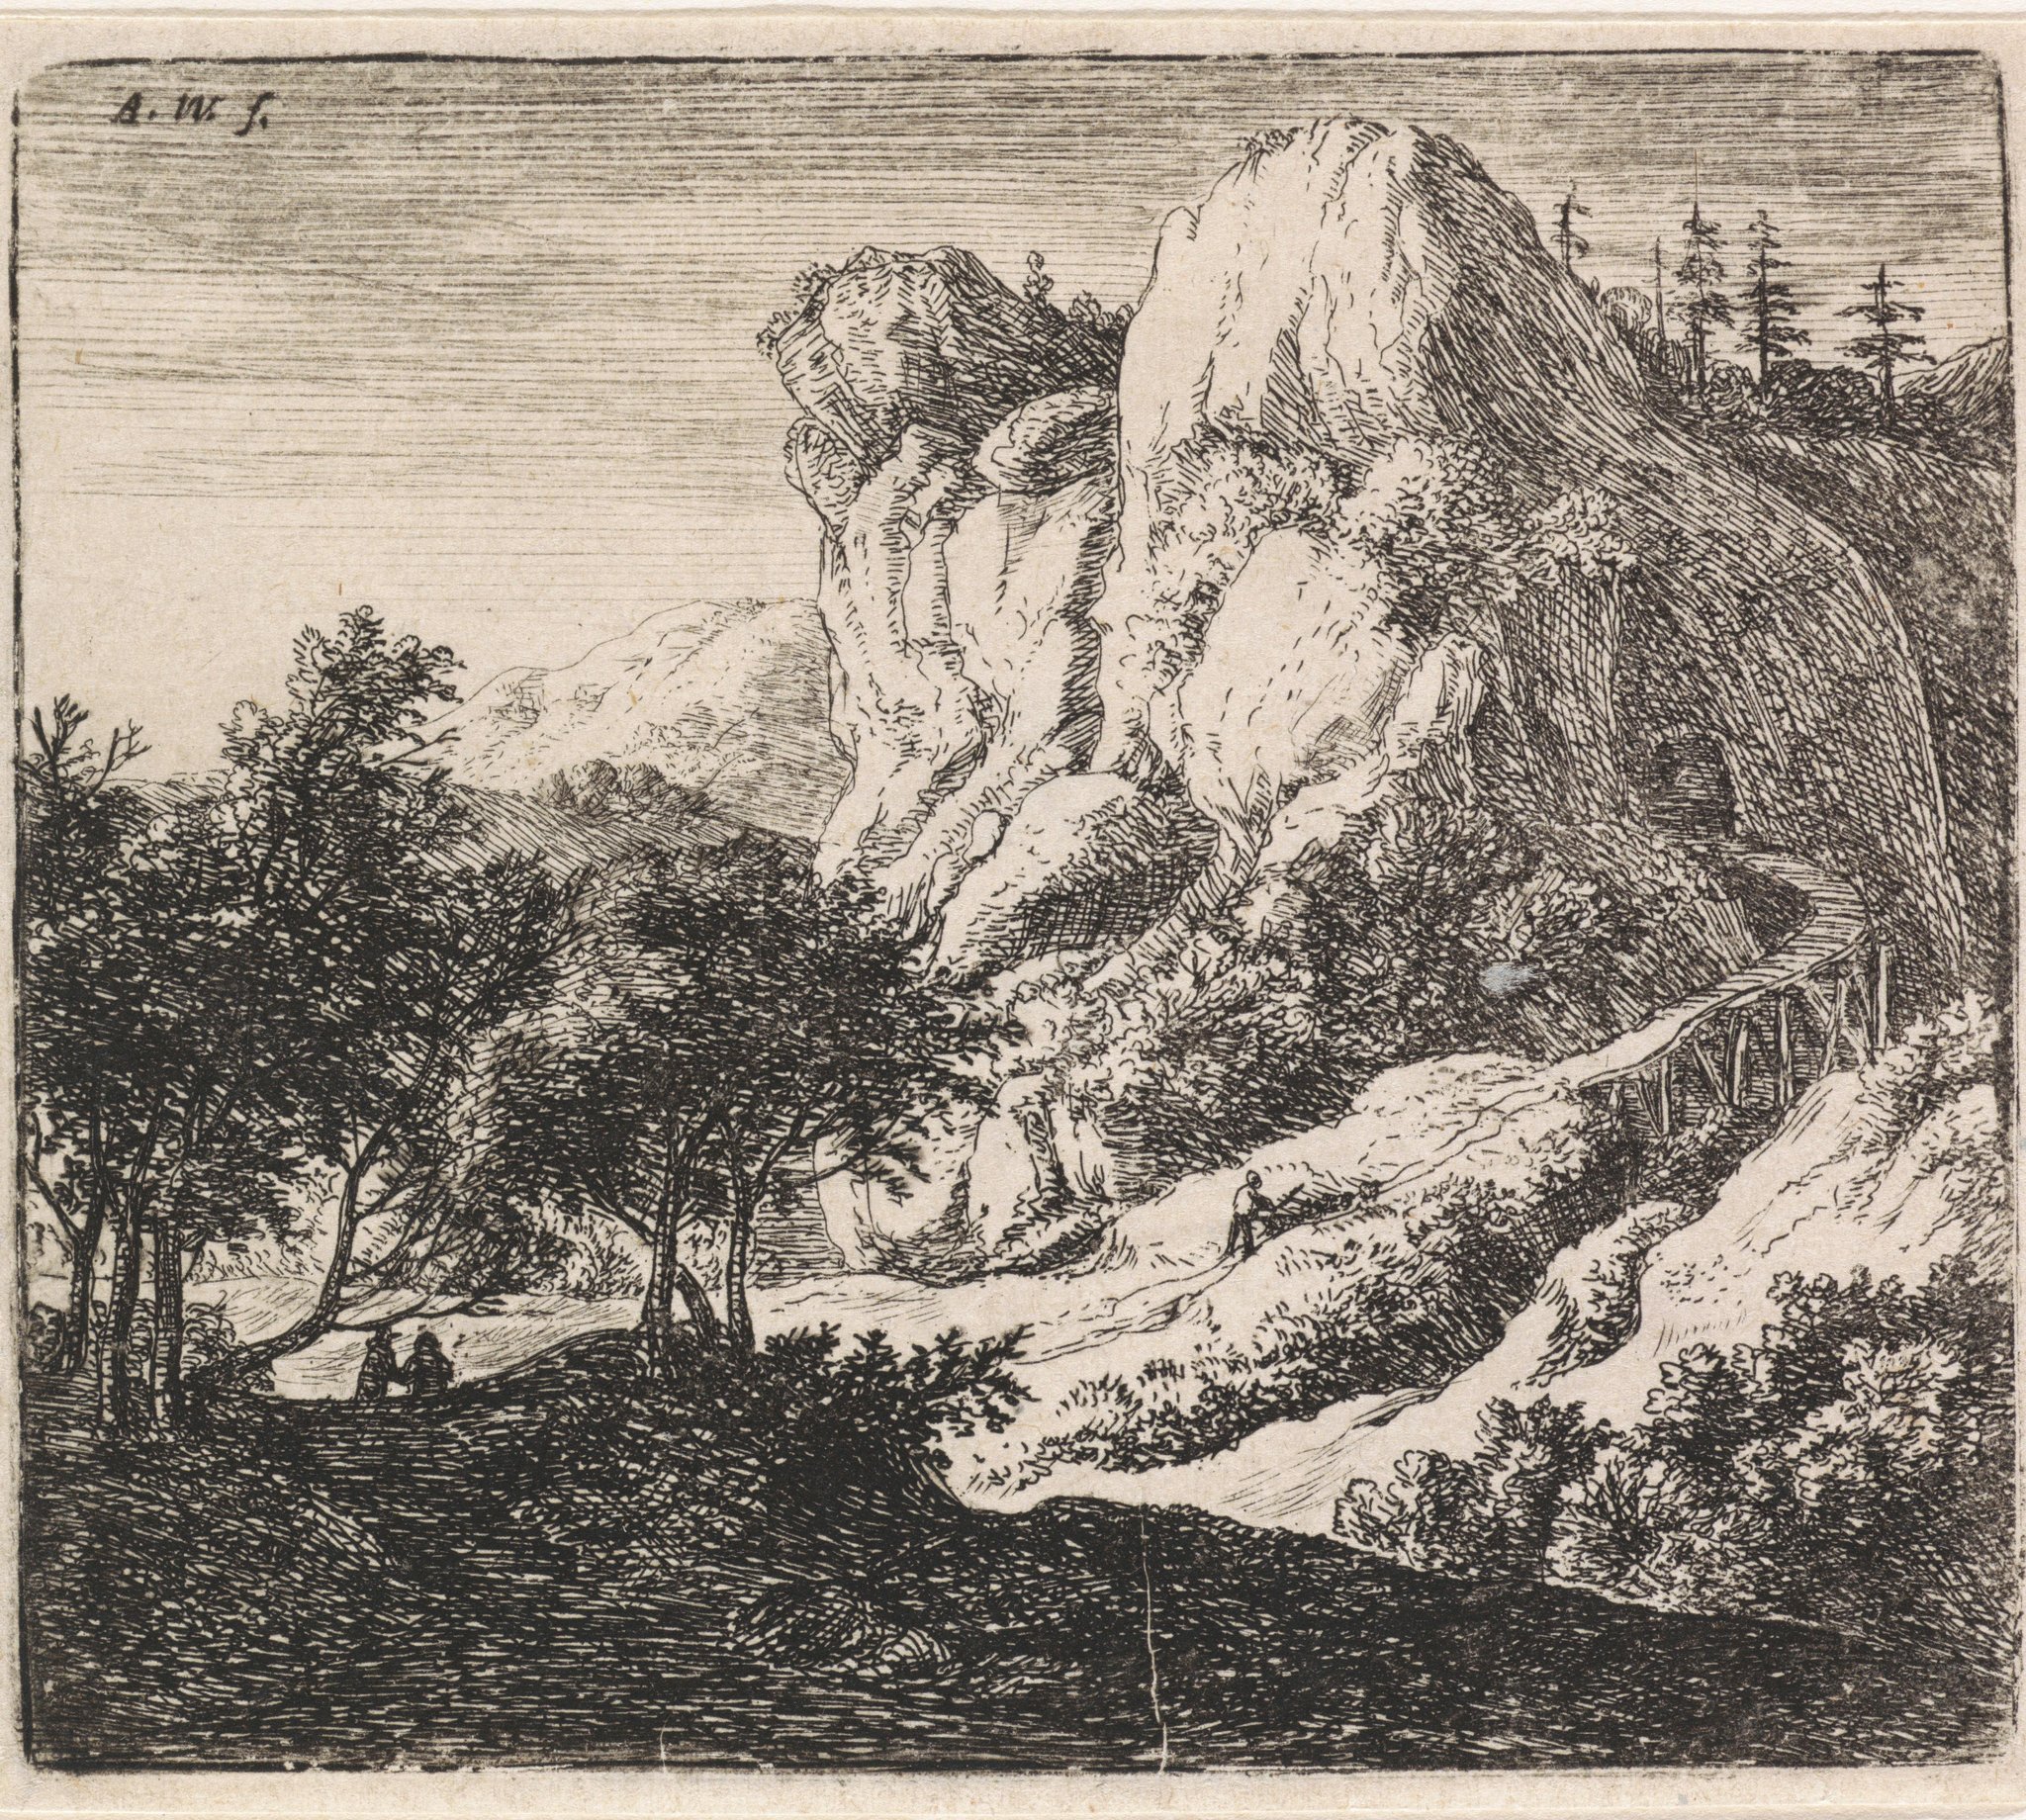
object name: print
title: Rotsachtige landschappen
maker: anthonie waterloo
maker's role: draughtsman, painter, print maker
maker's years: 1609-1690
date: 1630-1663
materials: paper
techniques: etching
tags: herding, herdsman, herdswoman, shepherd, shepherdess, cowherd, etc., bridge, rocks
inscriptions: collector's mark: Lugt 240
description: Rechts loopt een herder met zijn kudde in de richting van een houten brug die gedeeltelijk door een rotspartij voert. Linksvoor twee figuren onder bomen.